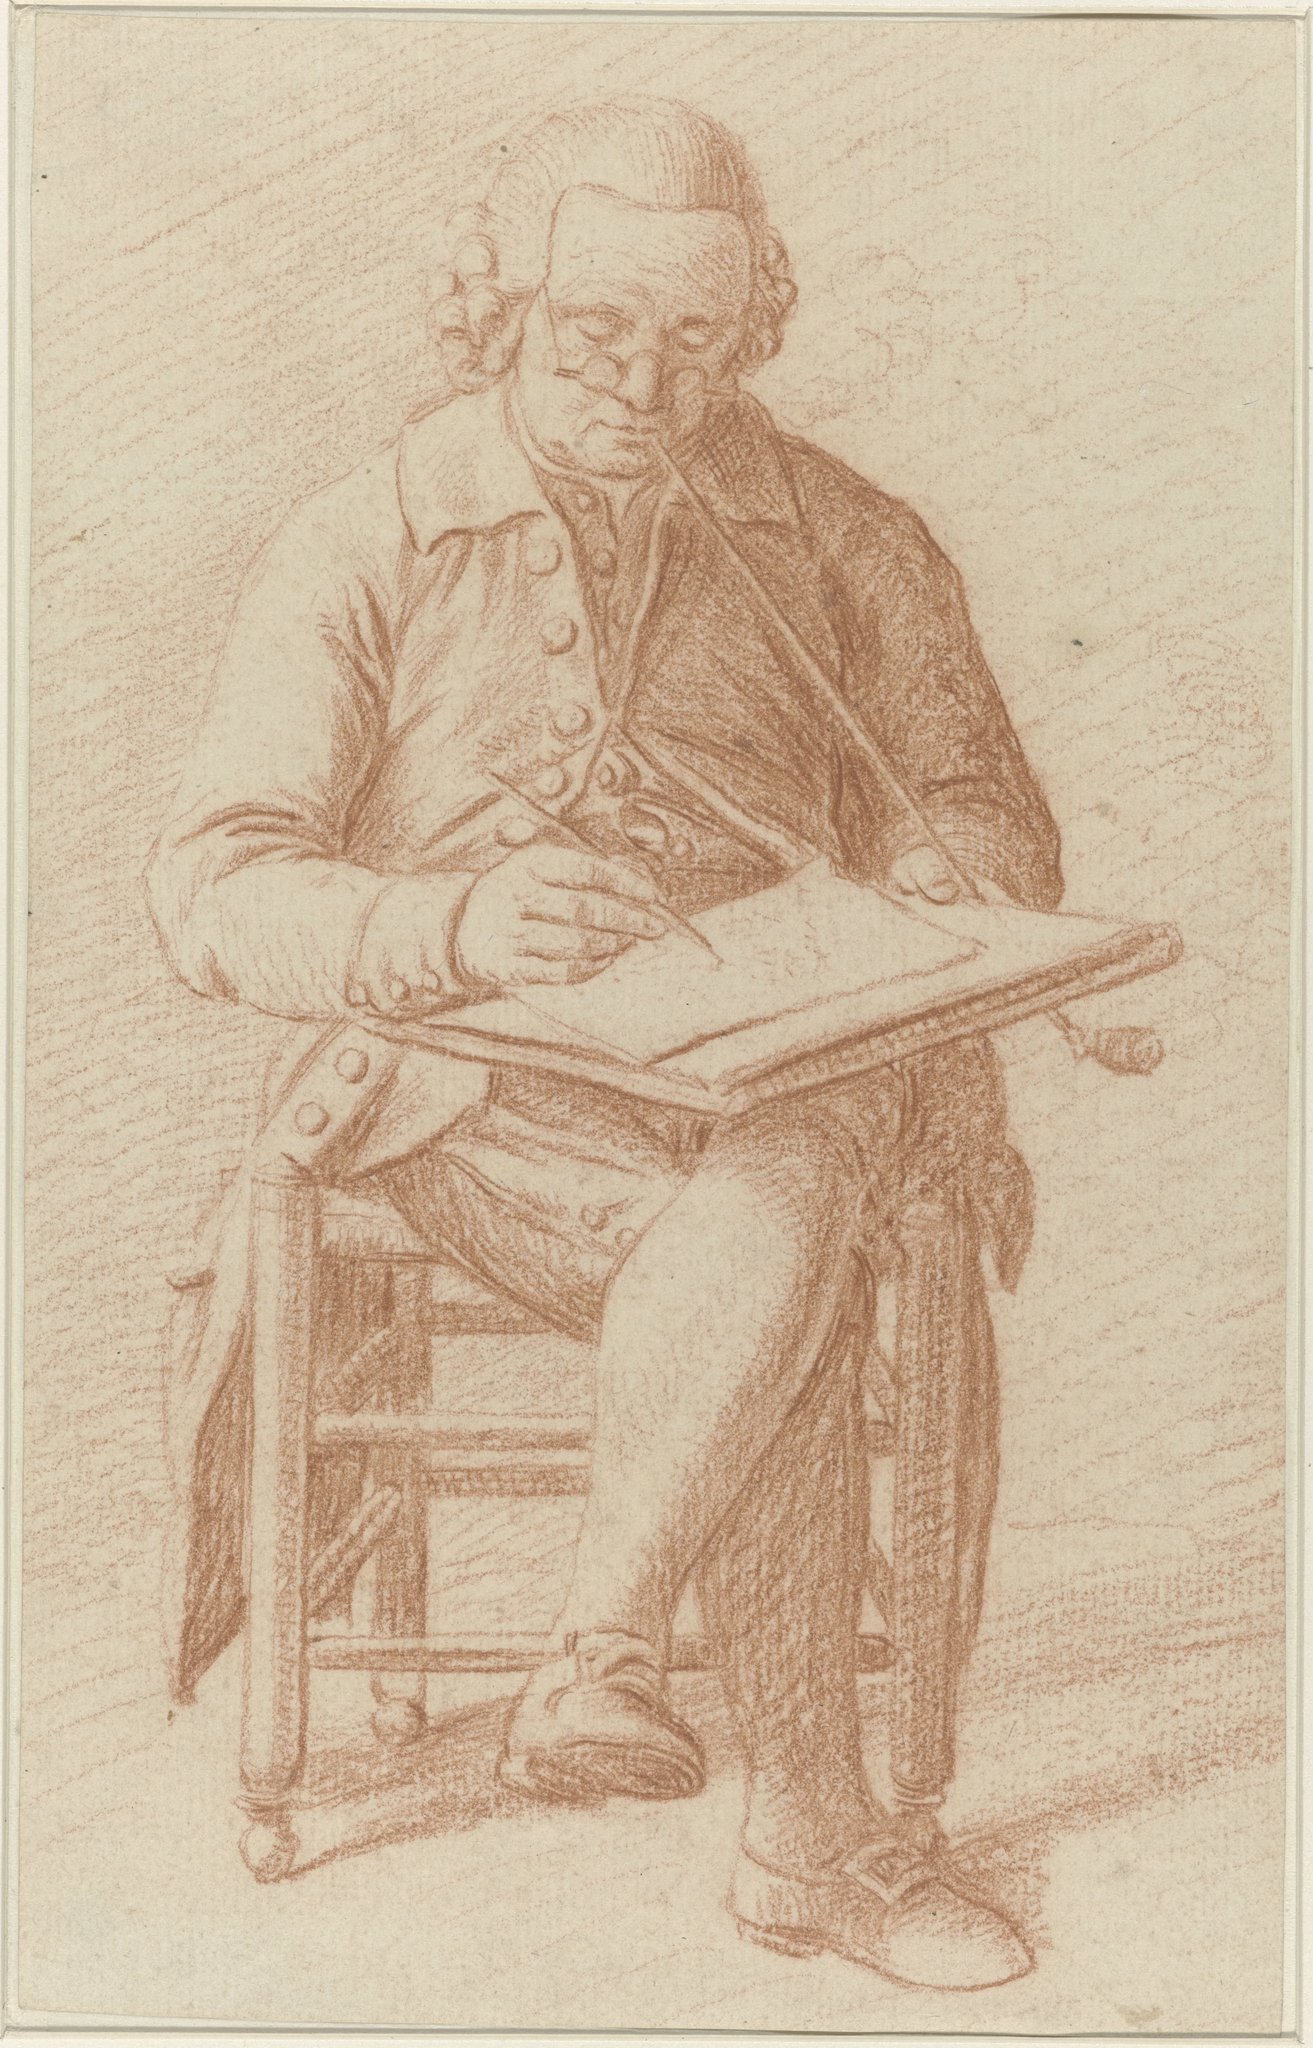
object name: drawing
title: Portret van Hendrik Tavenier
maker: johannes petrus van horstok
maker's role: draughtsman, painter, print maker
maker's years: 1745-1825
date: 1755-1825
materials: chalk, paper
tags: hendrik tavenier, historical persons, portrait, self-portrait of painter, portrait, self-portrait of artist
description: Portret van de schilder Hendrik Tavenier.